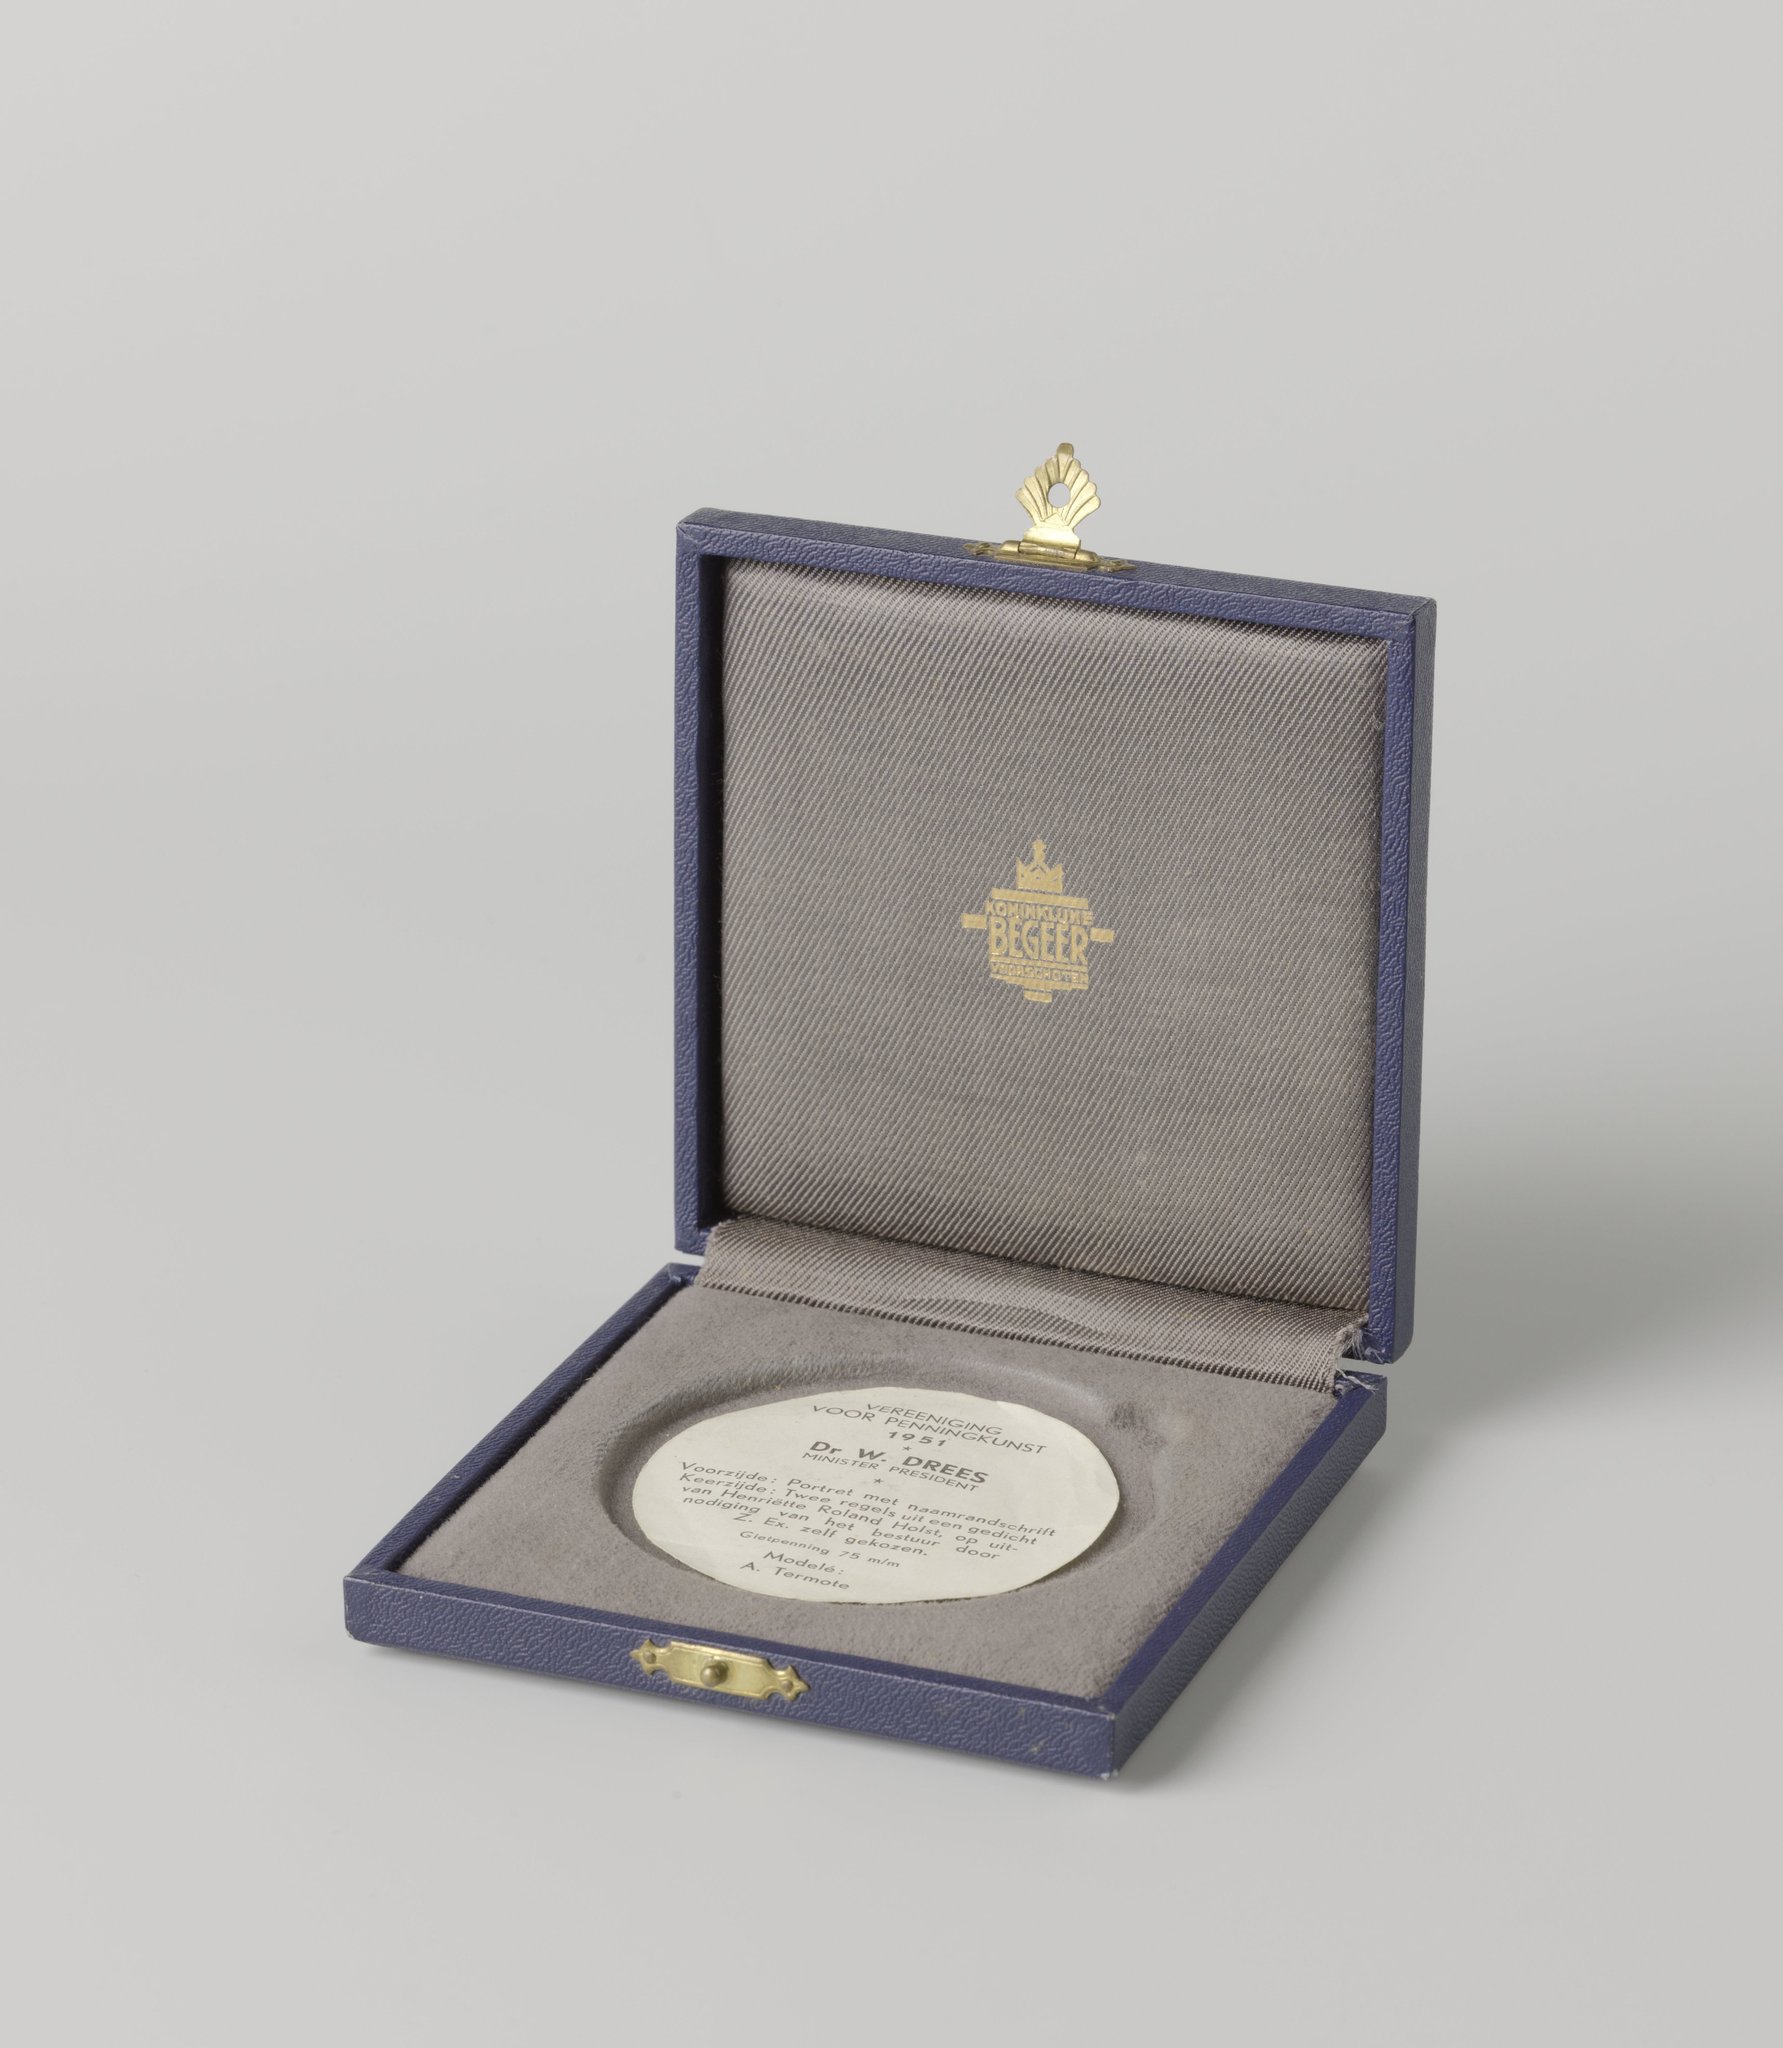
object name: box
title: Doos bij penning Dr W. Drees, minister president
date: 1951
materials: copper, leather, textile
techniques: pasting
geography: voorschoten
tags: amsterdam, the hague, willem drees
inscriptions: mark: ‘KONINKLIJKE BEGEER VOORSCHOTEN’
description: Vierkant blauw leren doosje met bronzen sluiting, binnenzijde uitsparing voor penning en rond inlegvel, binnenzijde deksel merk fabrikant.